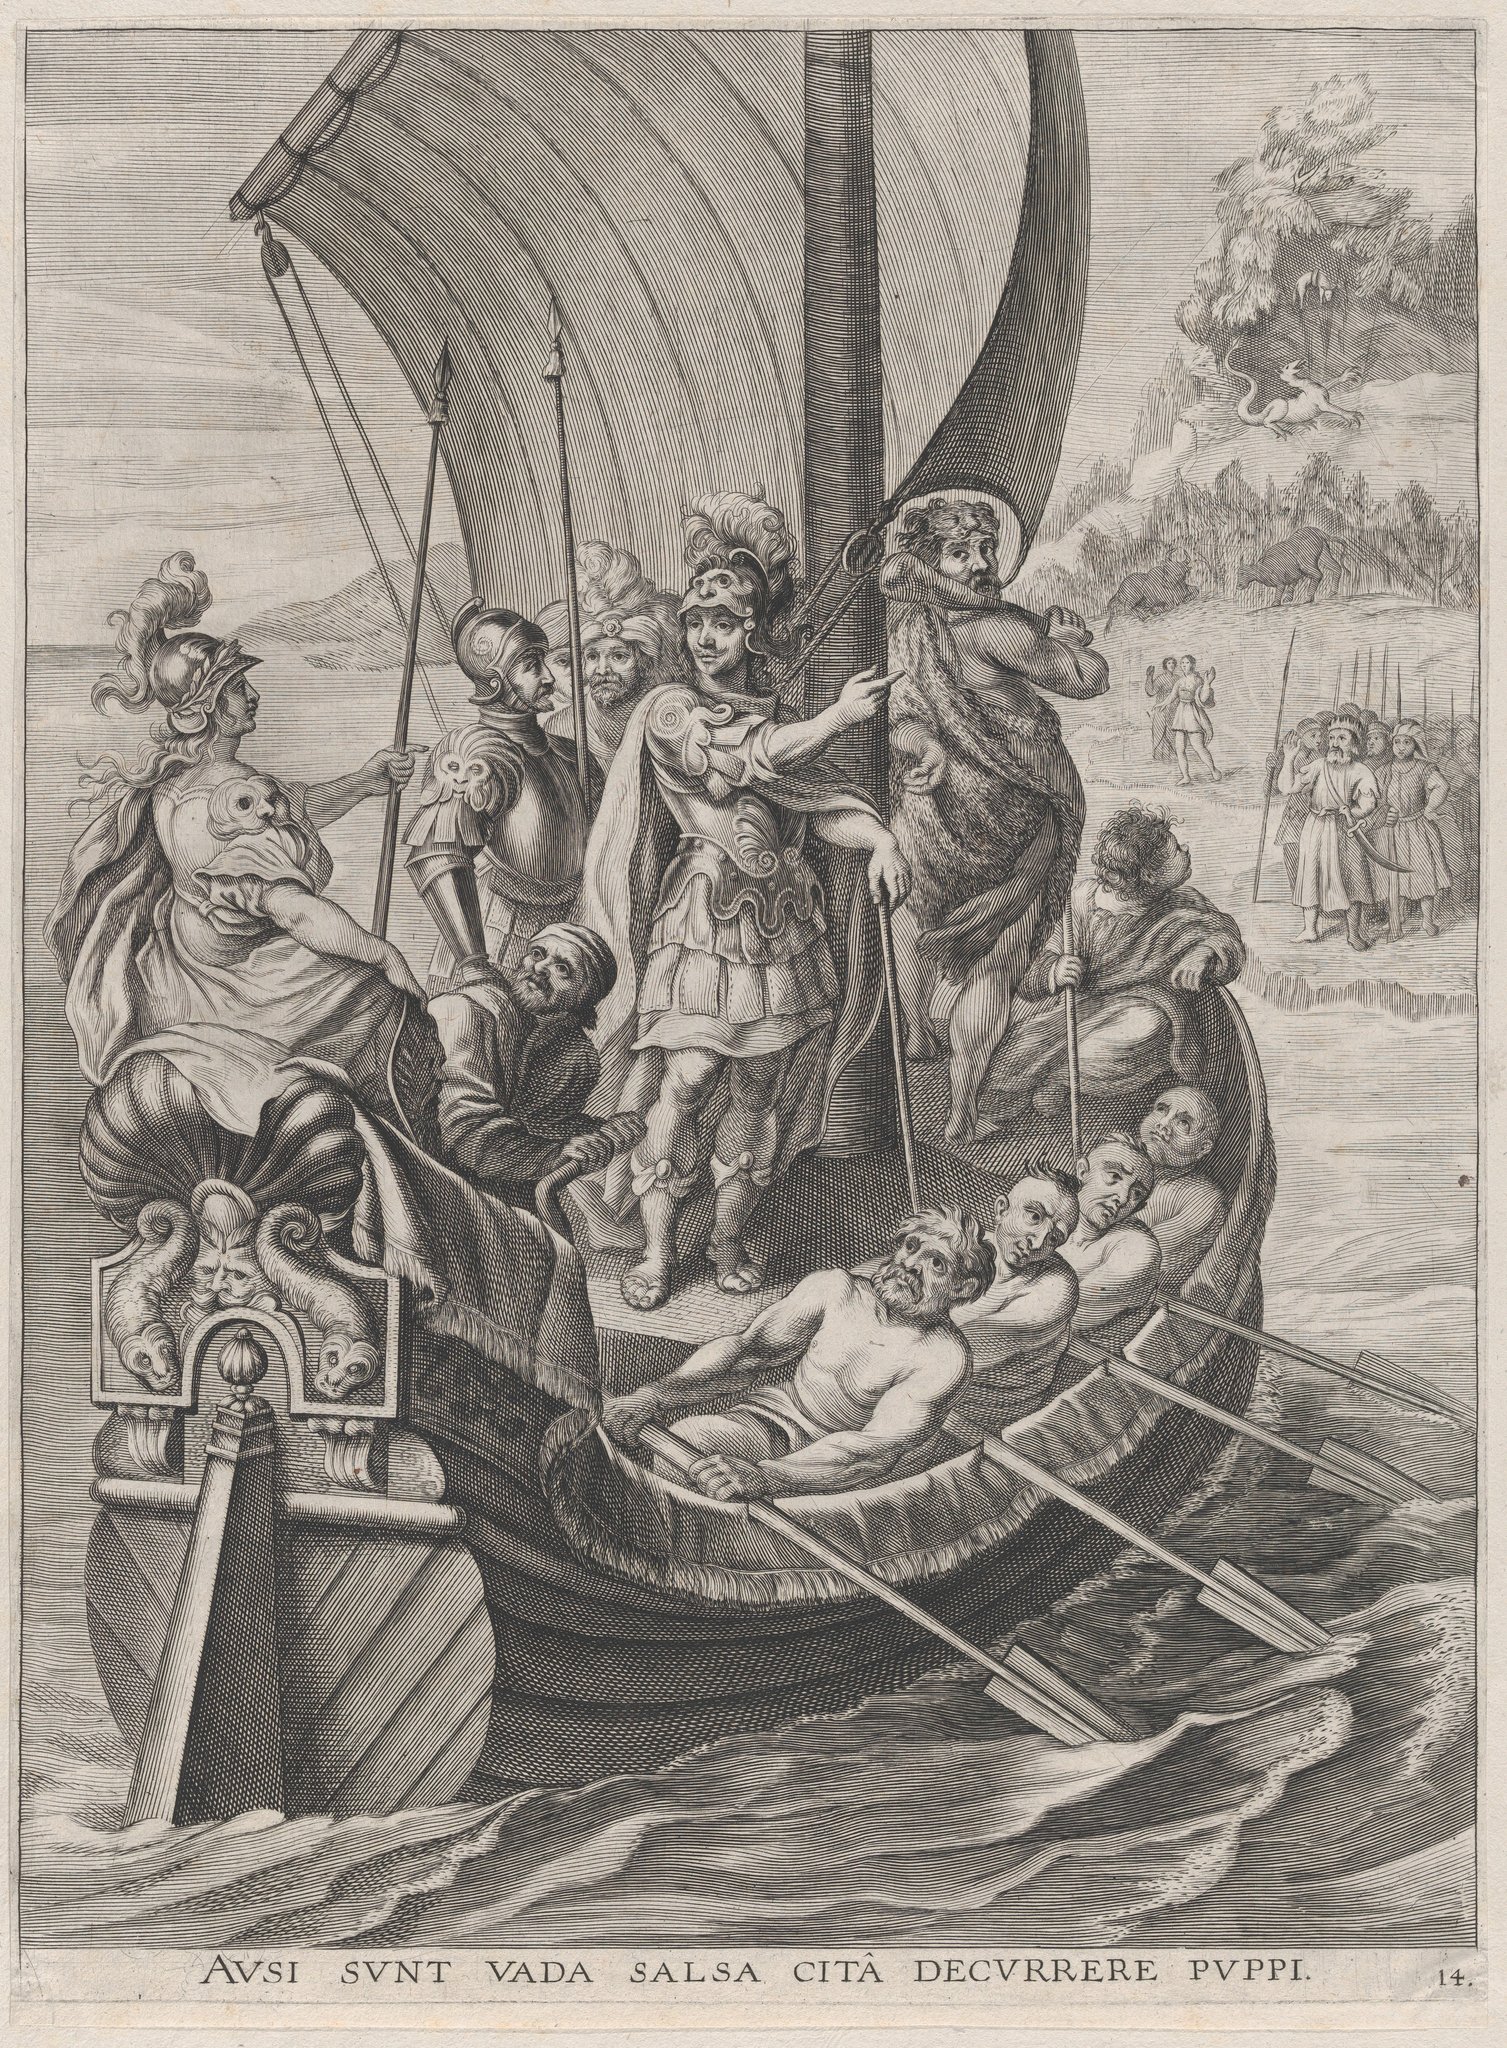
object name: print, fete, ornament architecture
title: Plate 14: Ferdinand on a voyage with the Argonauts; from Guillielmus Becanus's 'Serenissimi Principis Ferdinandi, Hispaniarum Infantis...'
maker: jacobus van schoor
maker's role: artist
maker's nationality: flemish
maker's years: 1600-1699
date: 1636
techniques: engraving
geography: antwerp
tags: kings,men,rowing,argonauts,boats